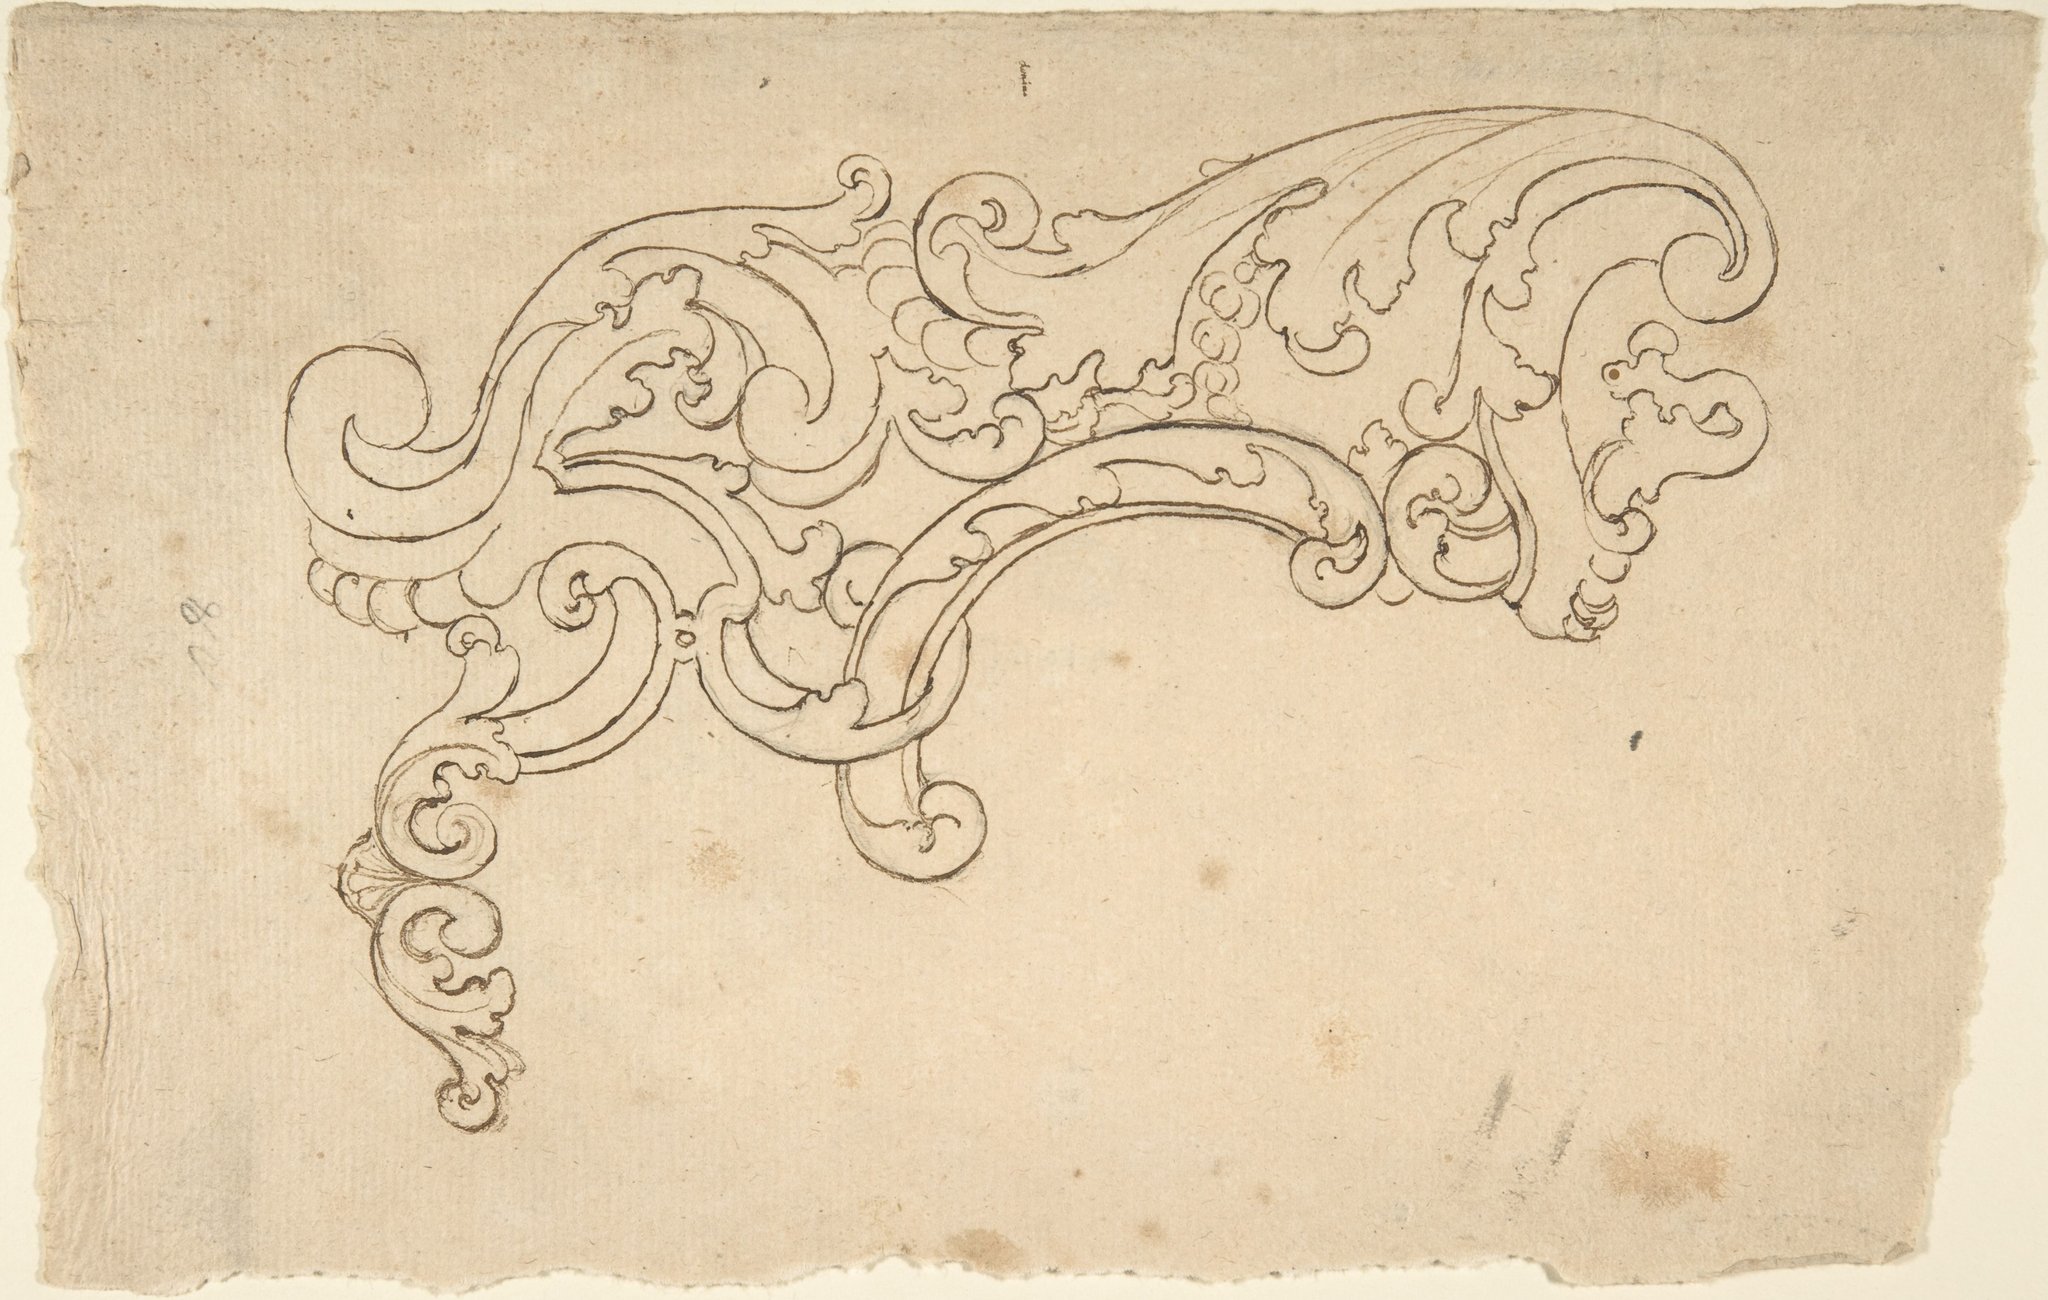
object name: drawing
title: Design of Scroll (Part of a Cartouche ?)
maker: anonymous, italian, piedmontese, 18th century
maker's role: artist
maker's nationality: italian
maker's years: 1700-1800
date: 1701-1800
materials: chalk, ink, paper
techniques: pen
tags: ornament